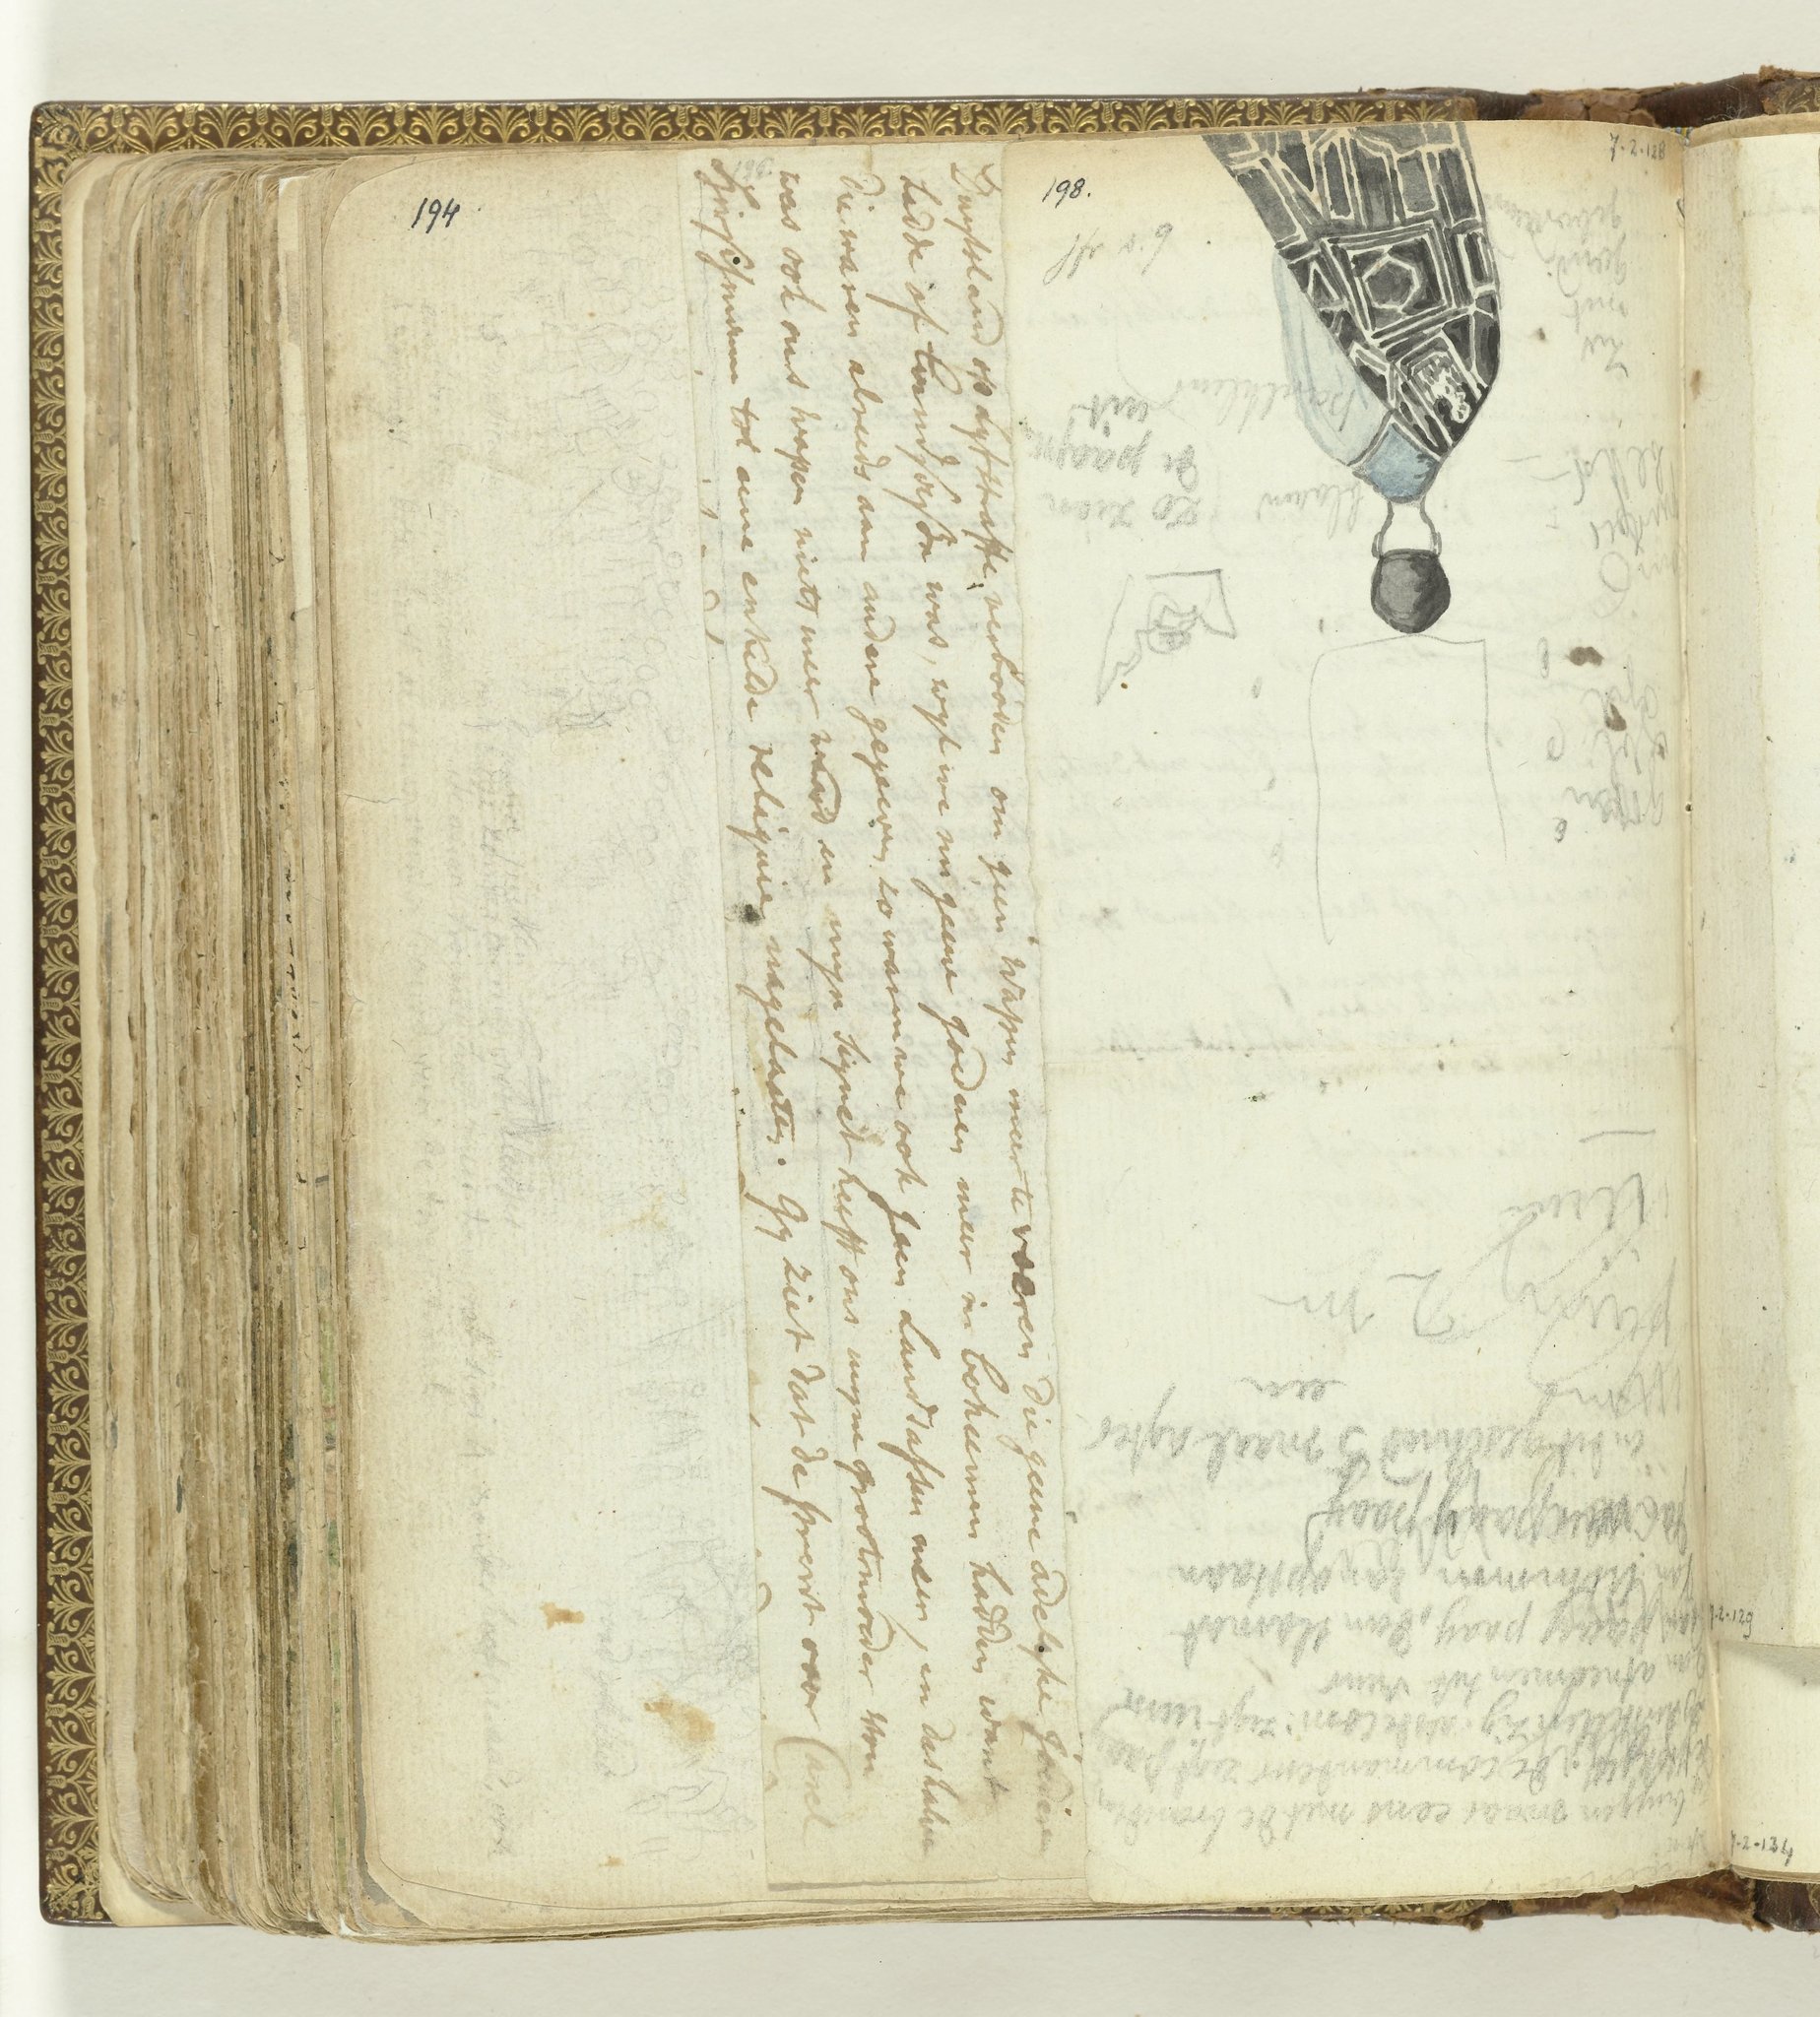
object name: drawing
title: Chineese geestelijke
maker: jan brandes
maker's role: draughtsman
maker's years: 1743-1808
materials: paper, pencil, watercolor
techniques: brush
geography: jakarta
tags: religious functionaries ~ traditional chinese religions, batavia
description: Kleurtekening van een Chinees op de rug gezien met een zwart gewaad met witte motieven. Zie deel 2, pp. 9, 10, 11. Met opschrift. Onderdeel uit het schetsboek van Jan Brandes, dl. 2 (1808), p. 198.